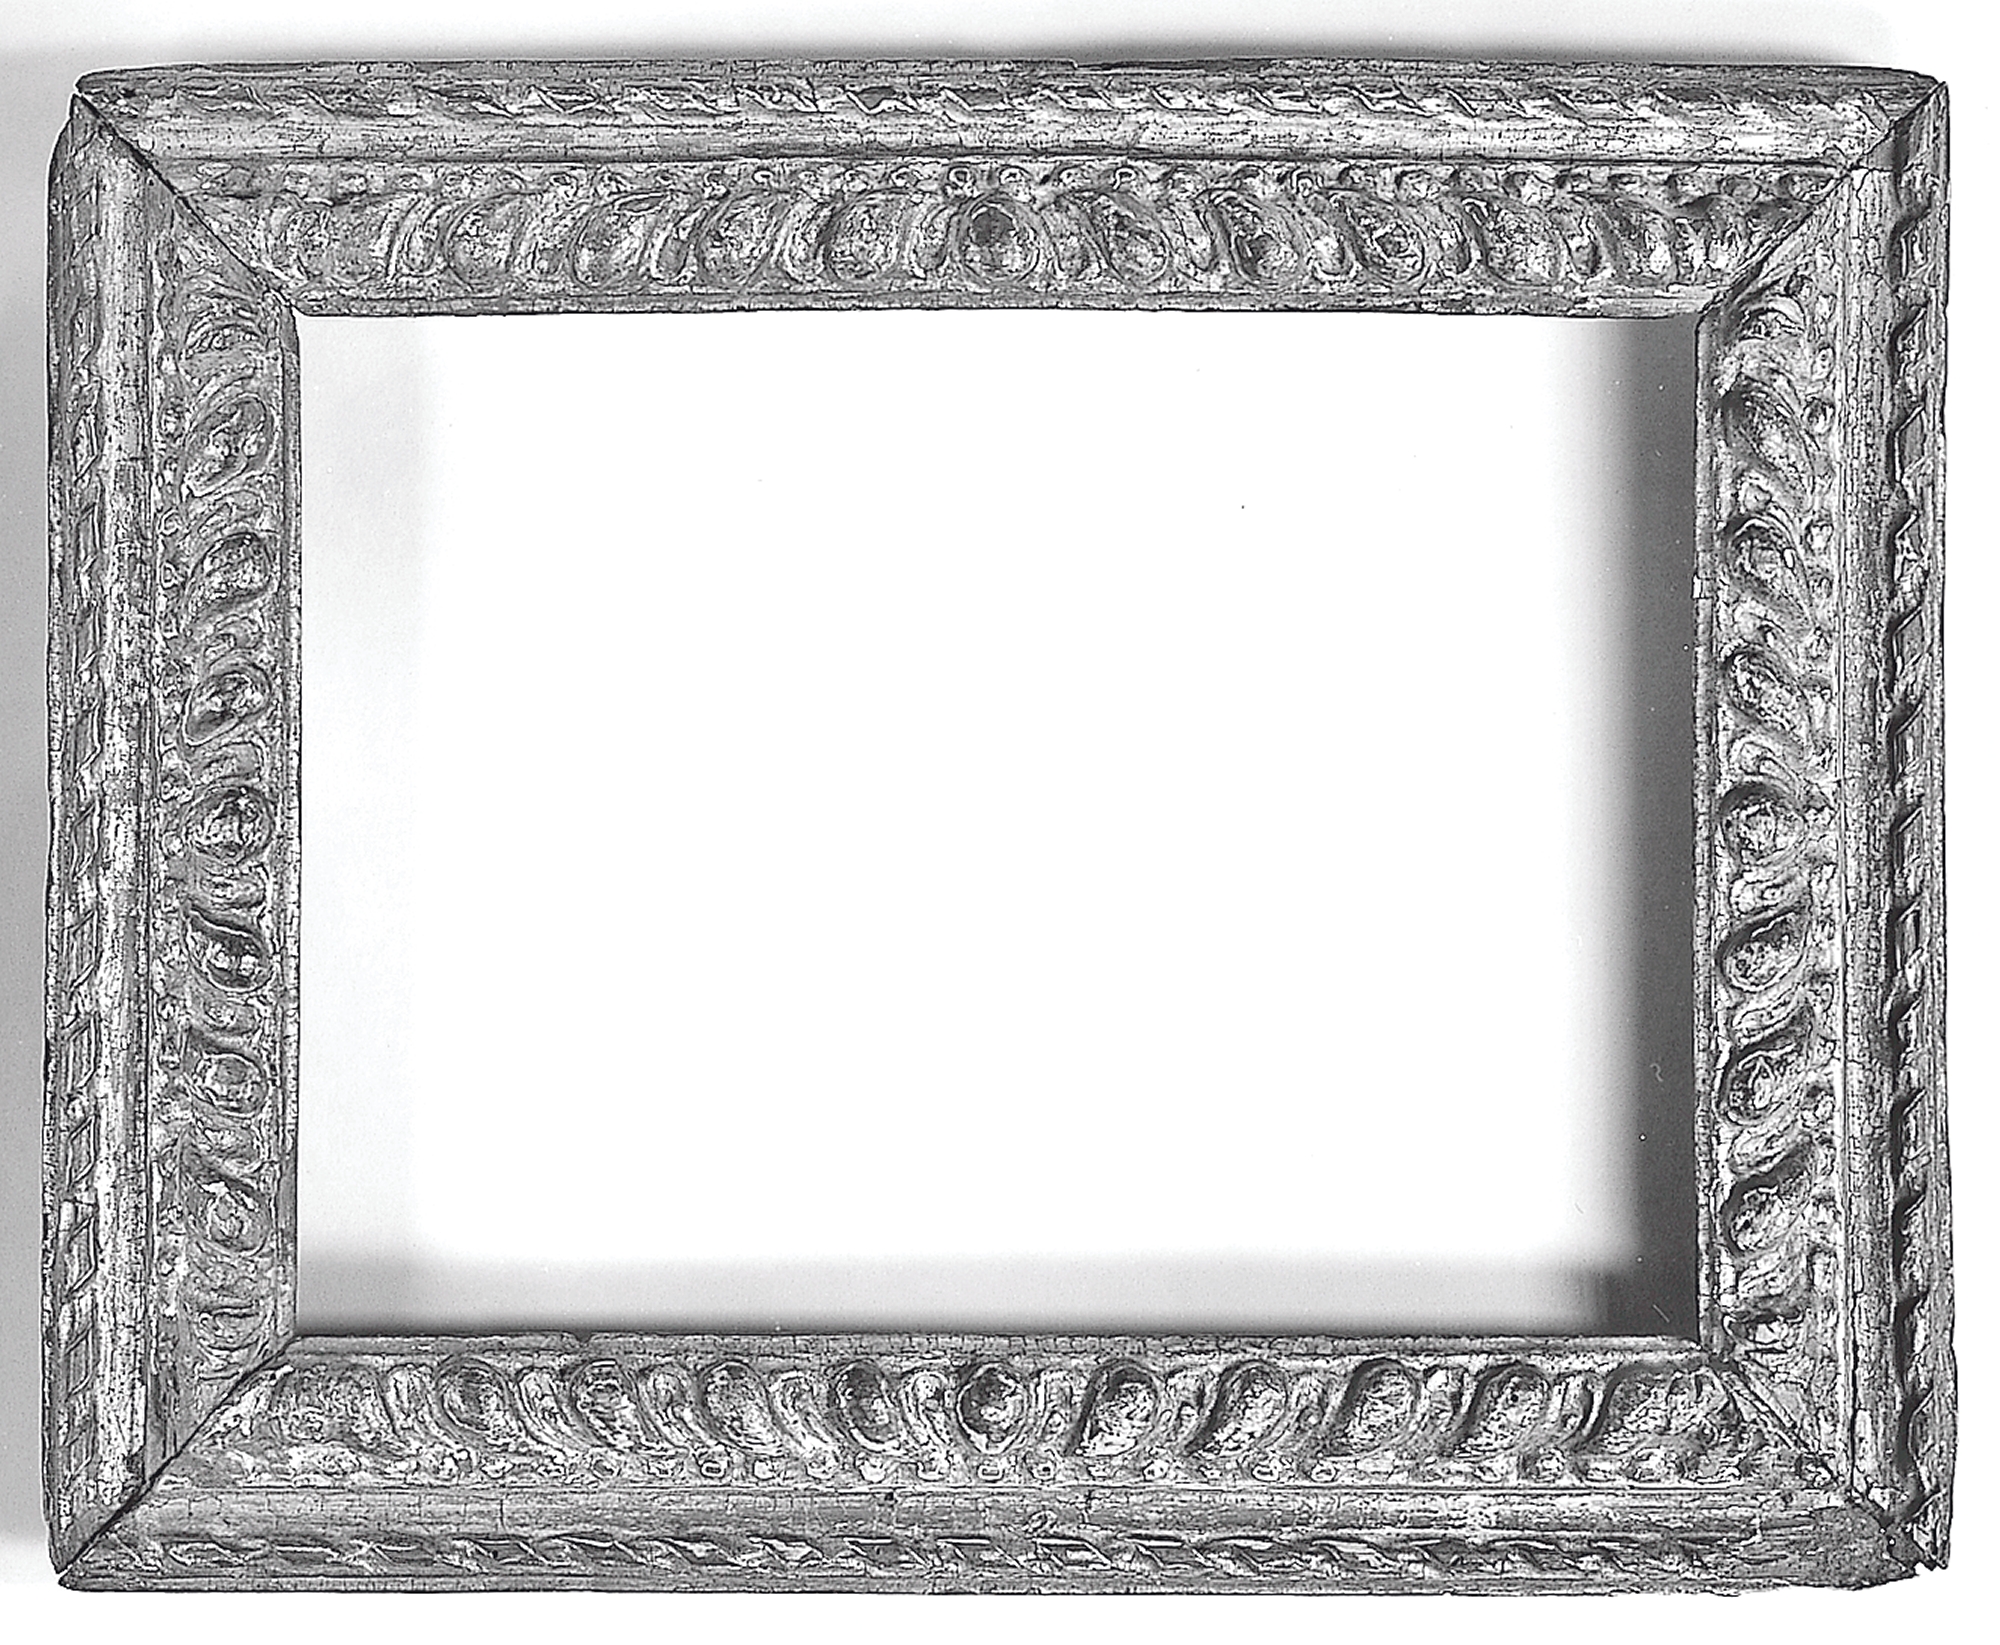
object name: frame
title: Reverse frame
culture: italian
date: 1650-1670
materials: wood